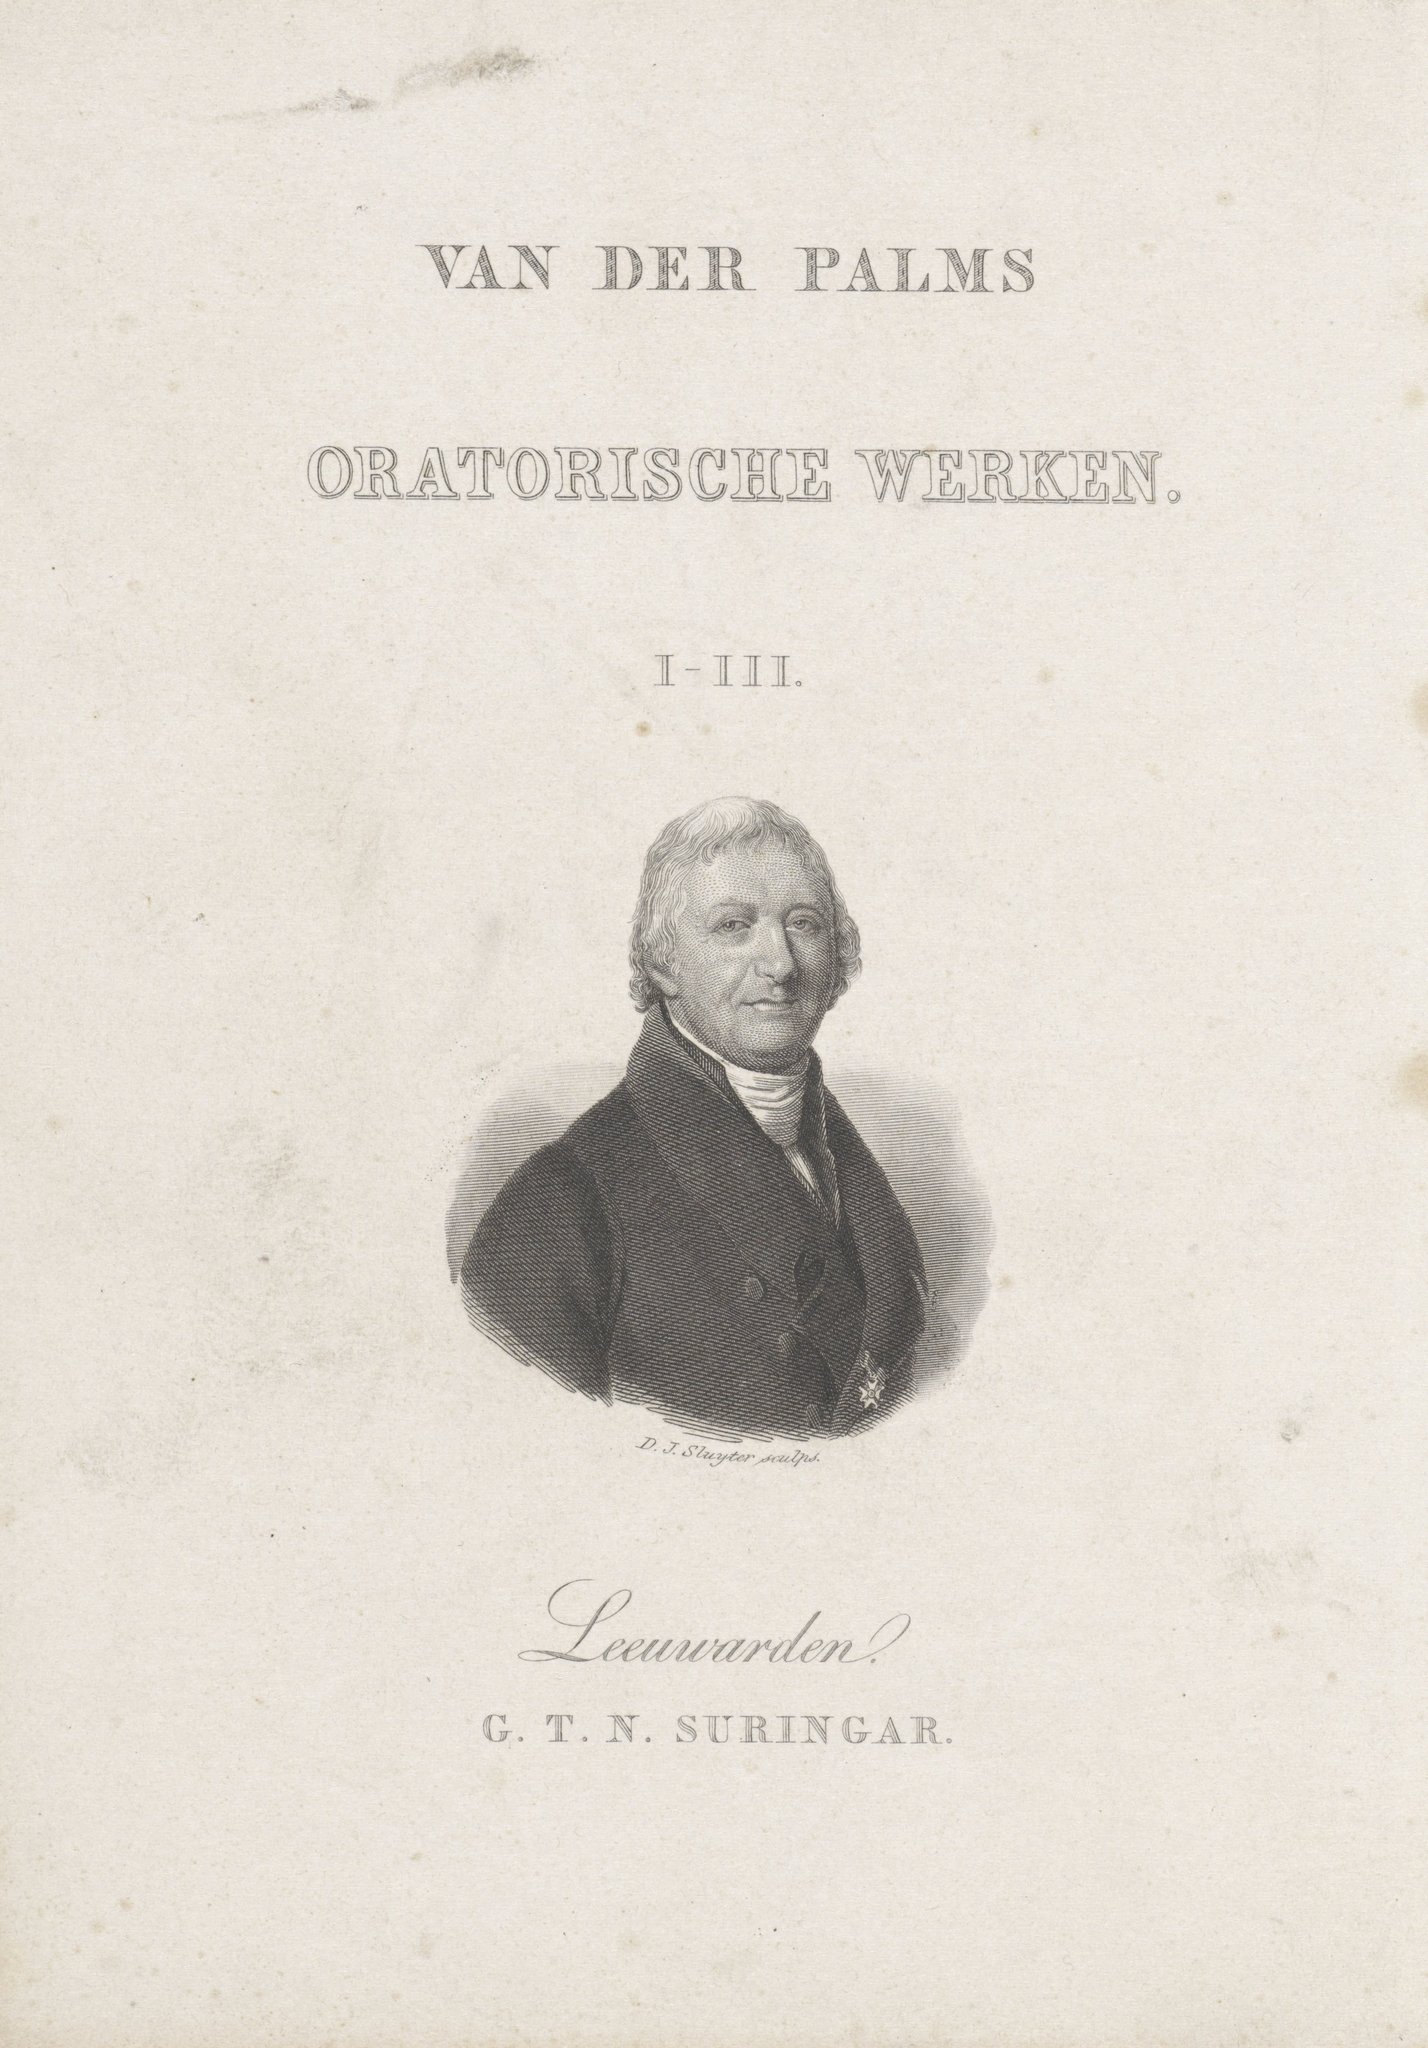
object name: print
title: Titelpagina voor: J.H. van der Palm, Redevoeringen, verhandelingen en losse geschriften, 1854-1855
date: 1854-1855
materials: paper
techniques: etching, engraving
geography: amsterdam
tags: rotterdam, johannes hendricus van der palm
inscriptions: collector's mark: Lugt 2228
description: Titelpagina voor: J.H. van der Palm. Redevoeringen, verhandelingen en losse geschriften. Leeuwarden: G.T.N. Suringar, 1854-1855.